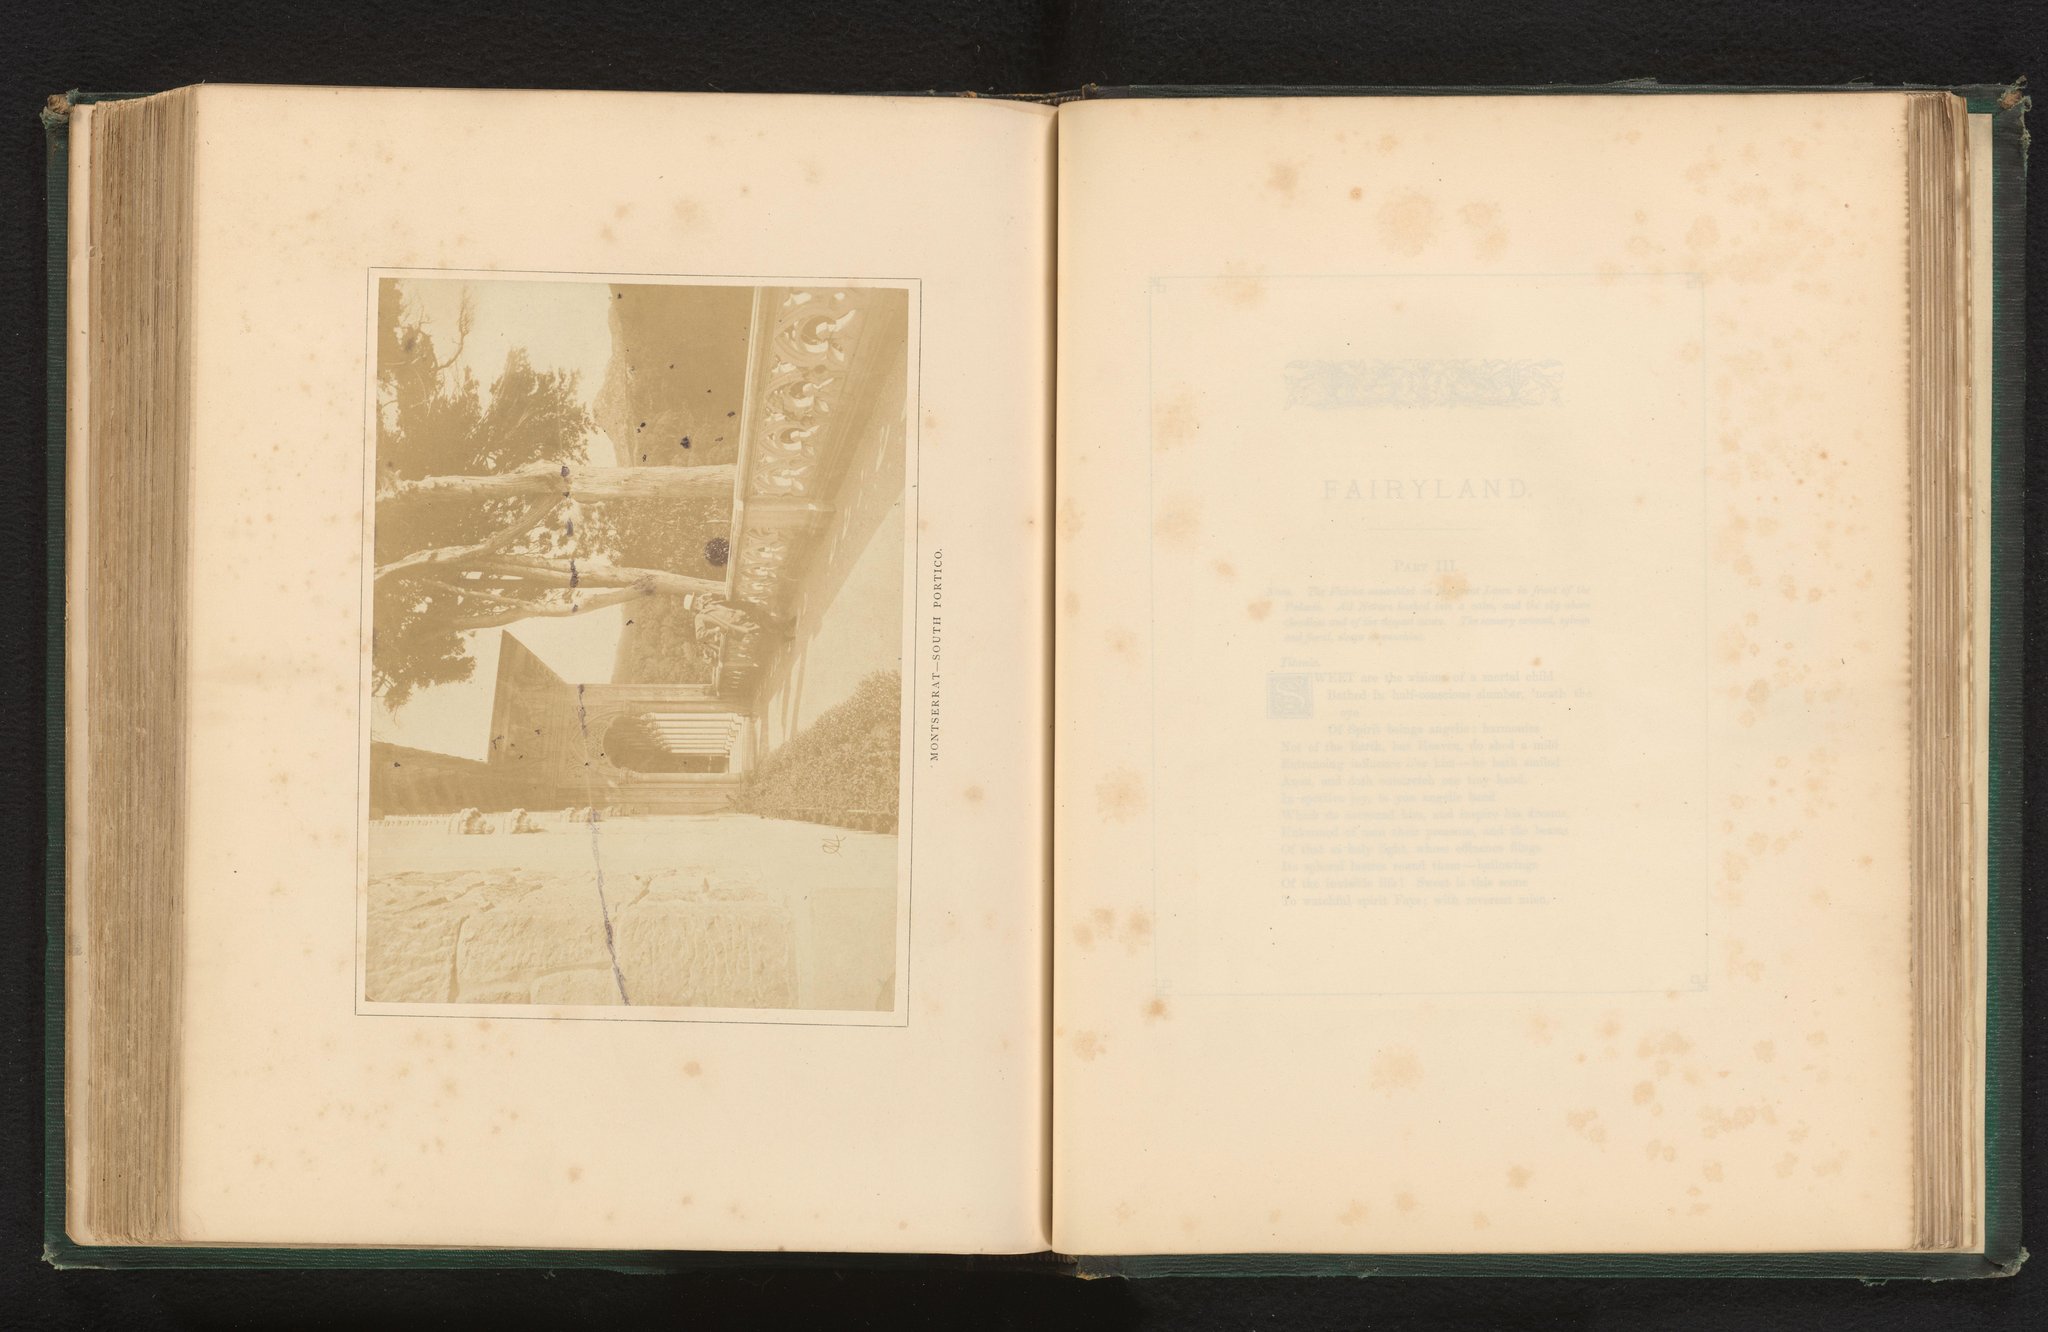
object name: page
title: Zuidelijke portico van het Palácio de Monserrate nabij Sintra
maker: Anonymous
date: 1865-1870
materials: paper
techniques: albumen print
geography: sintra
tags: colonnade, palace, gate, entrance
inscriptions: monogram: ‘M’